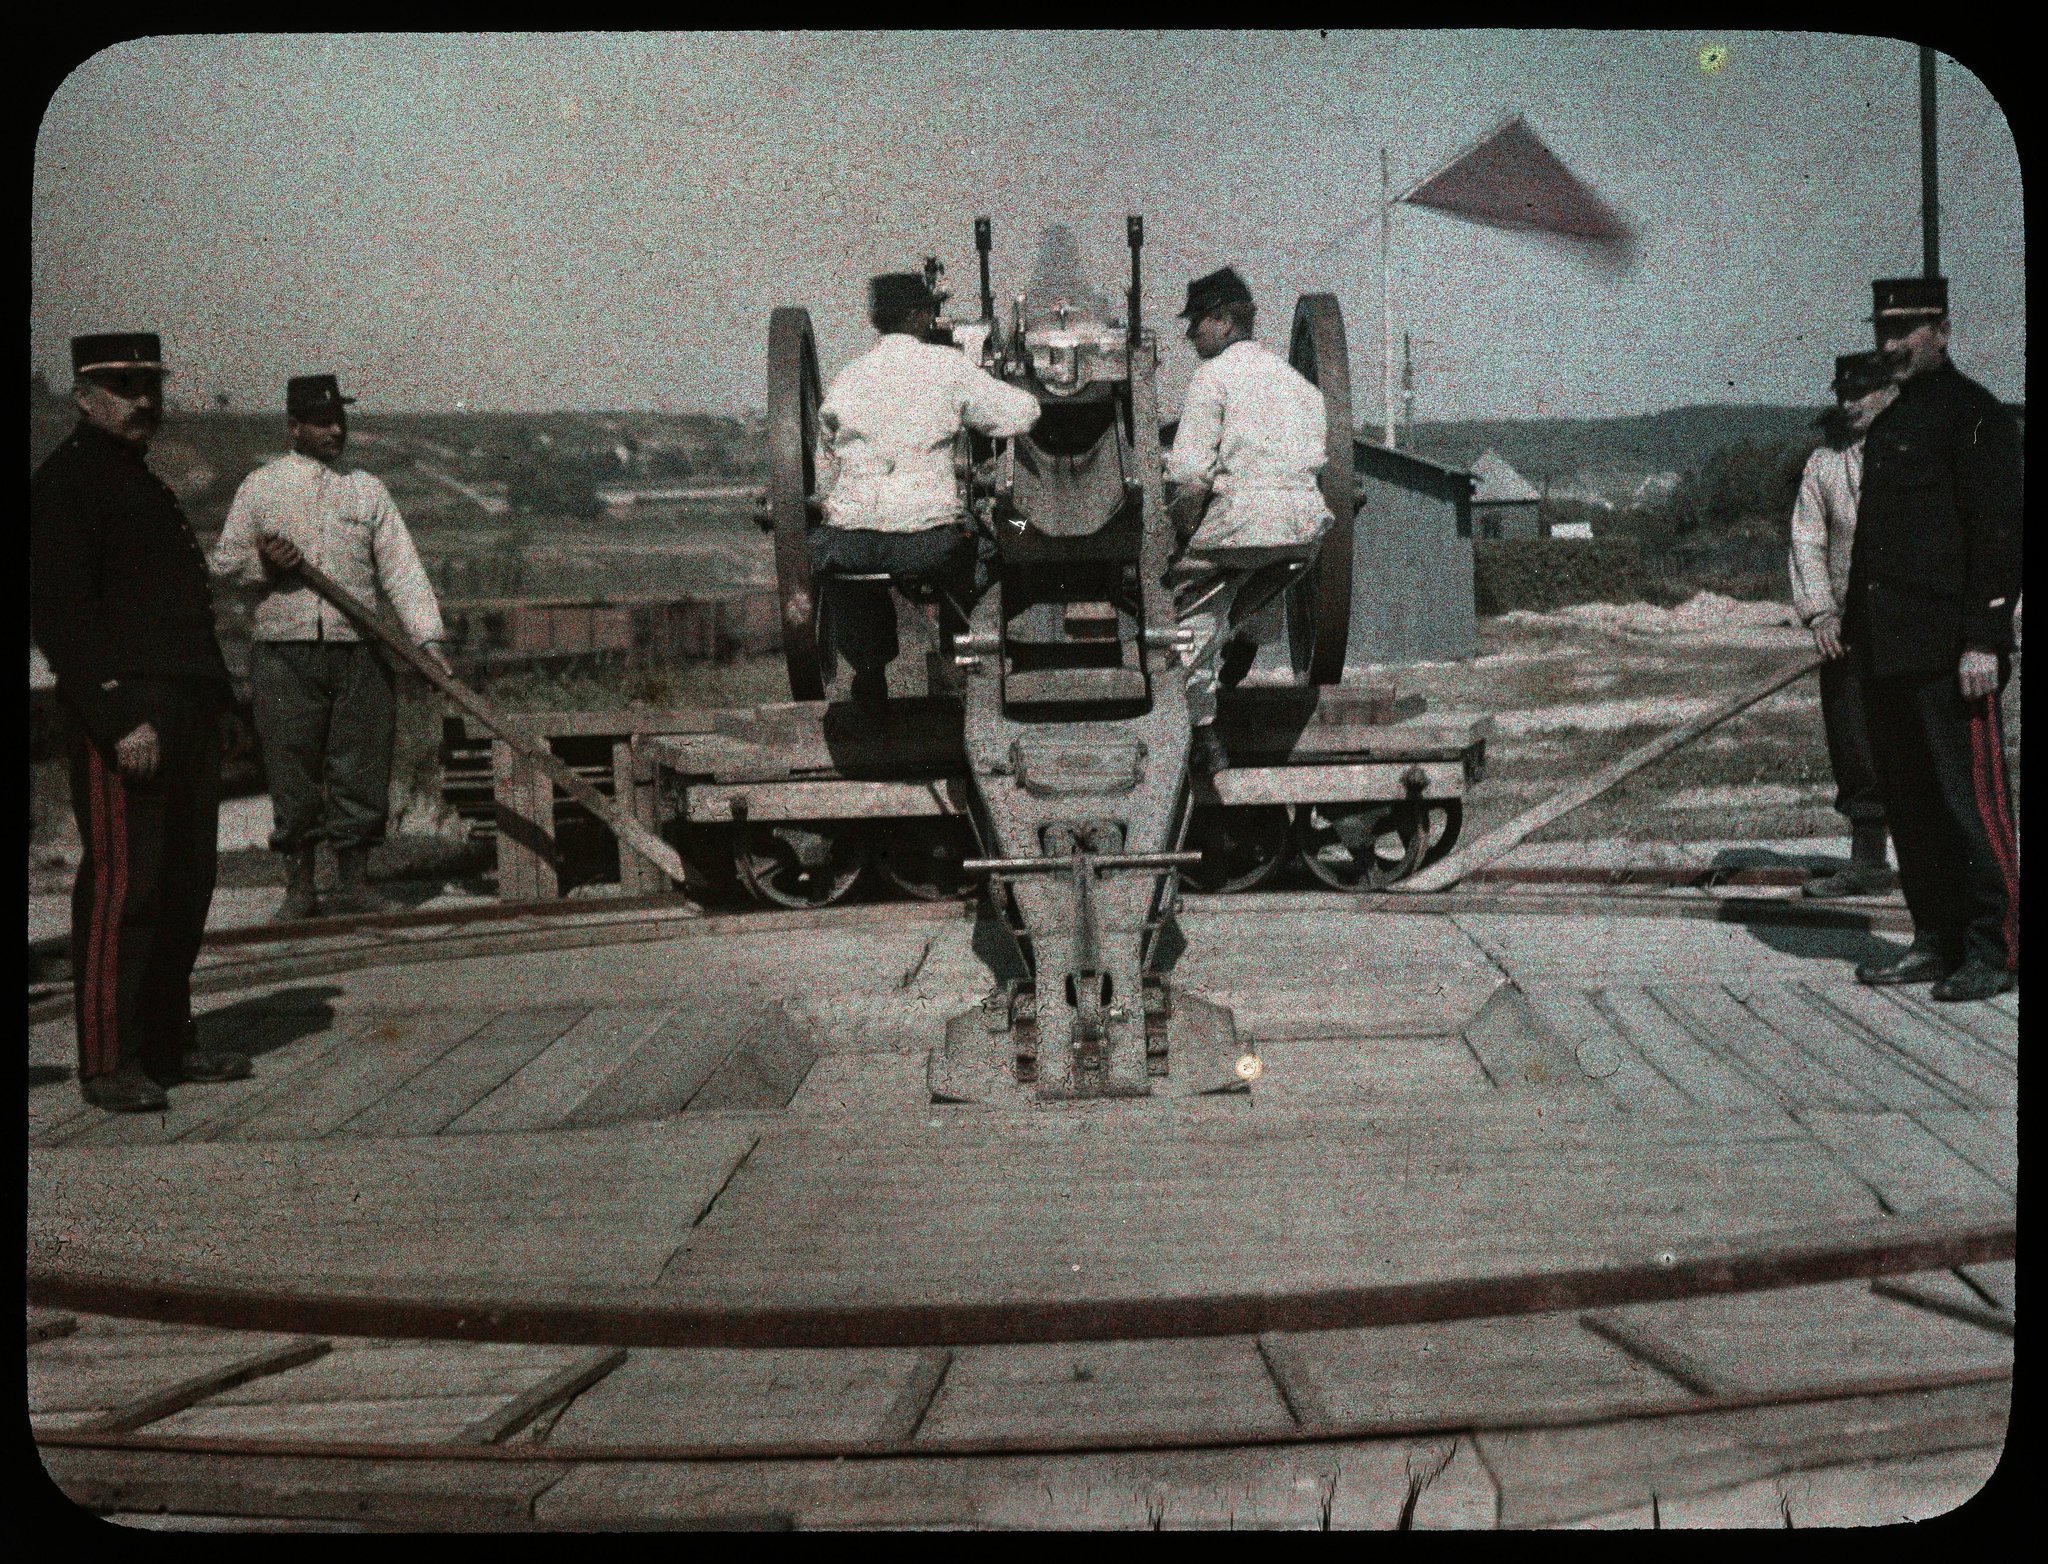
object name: glasdia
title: Kanonniers tijdens de Eerste Wereldoorlog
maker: Anonymous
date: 1914-1918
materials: glass, paper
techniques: autochrome process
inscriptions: : ‘.’